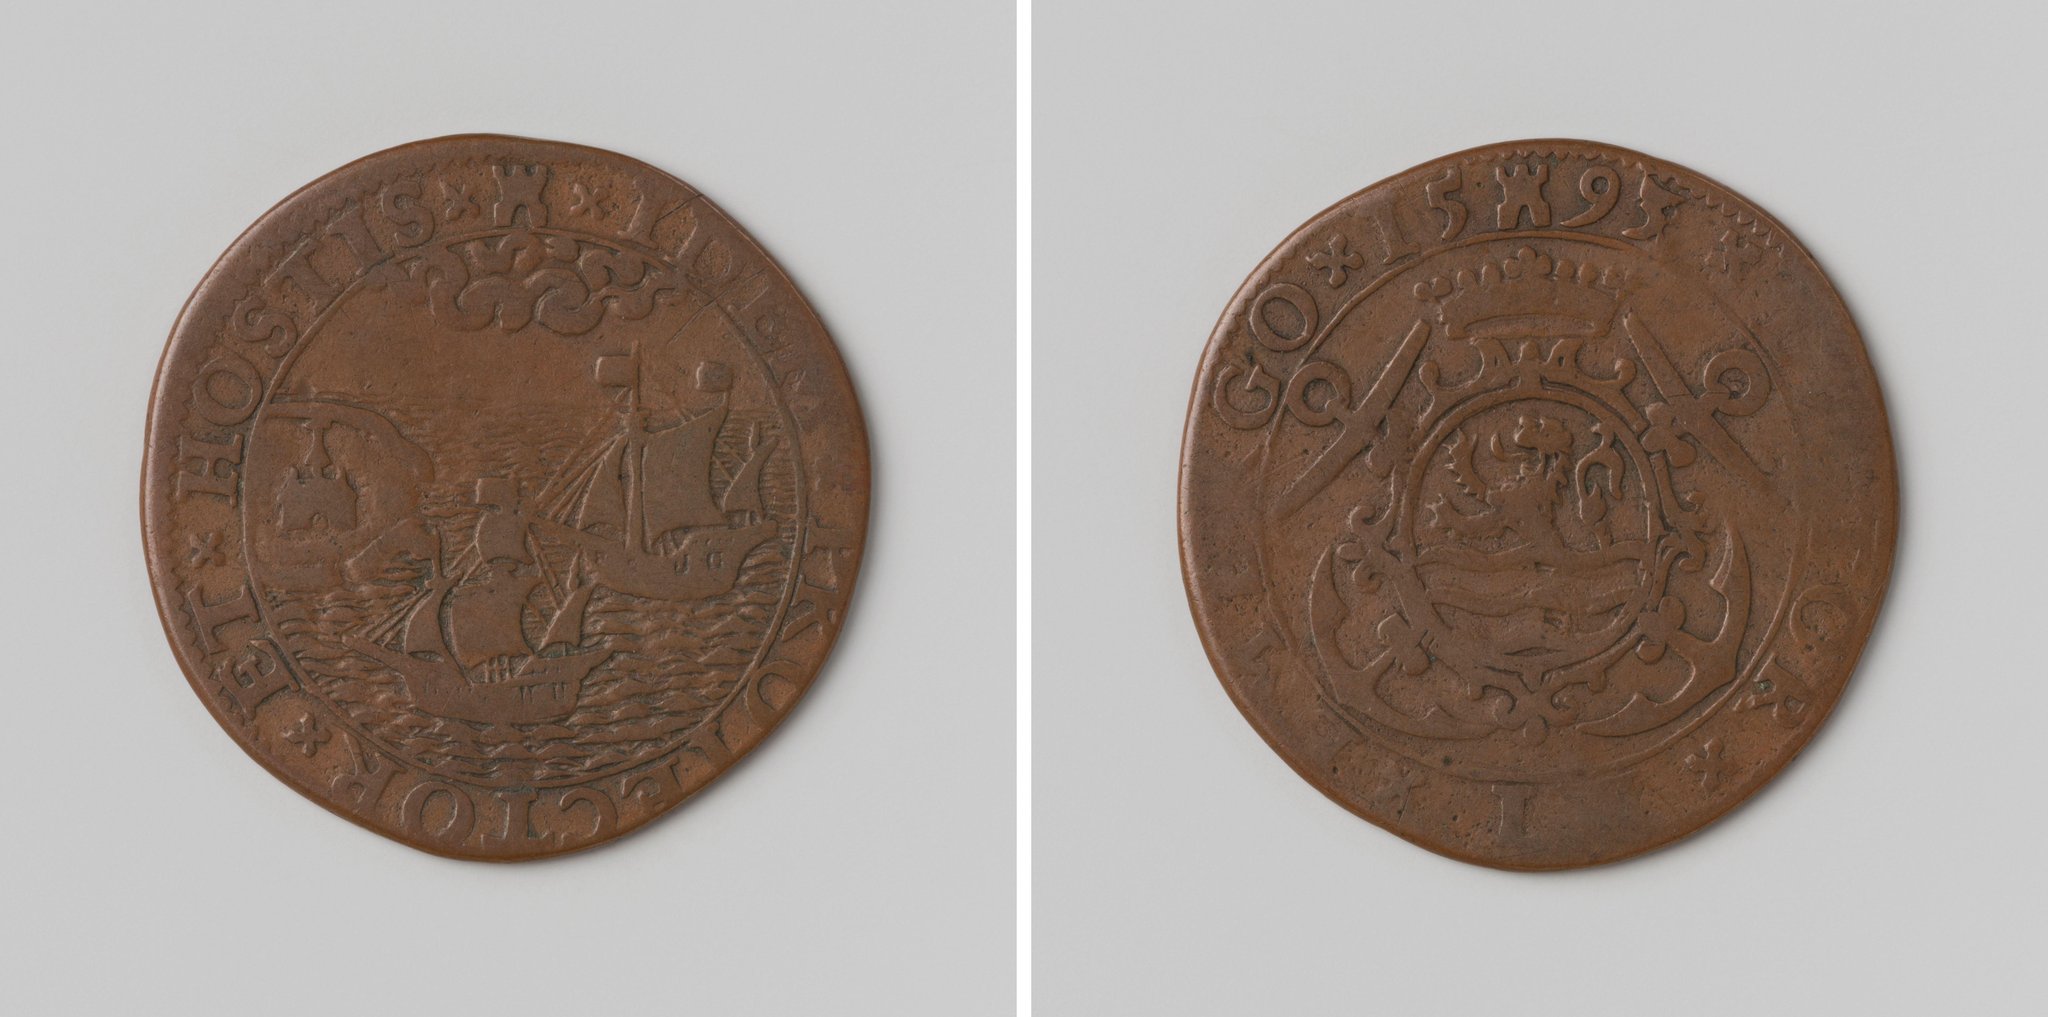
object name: jeton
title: Storm aan de Hollandse en Zeeuwse kusten, rekenpenning van de Staten van Zeeland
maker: Anonymous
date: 1593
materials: copper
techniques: striking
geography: middelburg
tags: zeeland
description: Koperen penning. Voorzijde: twee schepen voor eiland binnen omschrift. Keerzijde: gekroond wapenschild op twee gekruiste ankers binnen omschrift